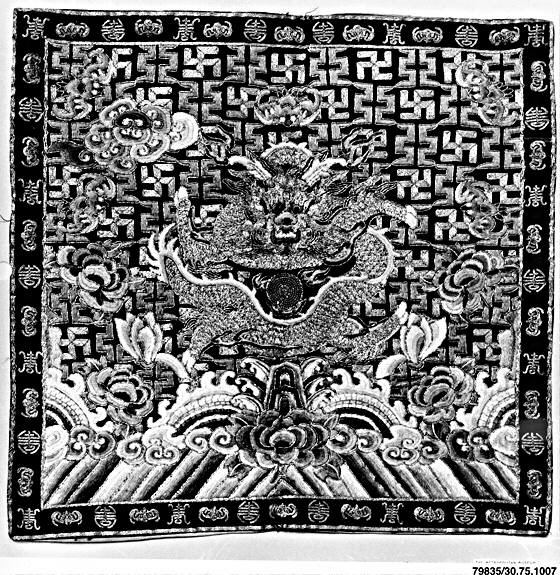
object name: rank badge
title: Rank Badge with Dragon with Deer Hooves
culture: chinese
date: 1767-1833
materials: metal thread, silk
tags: bats,dragons